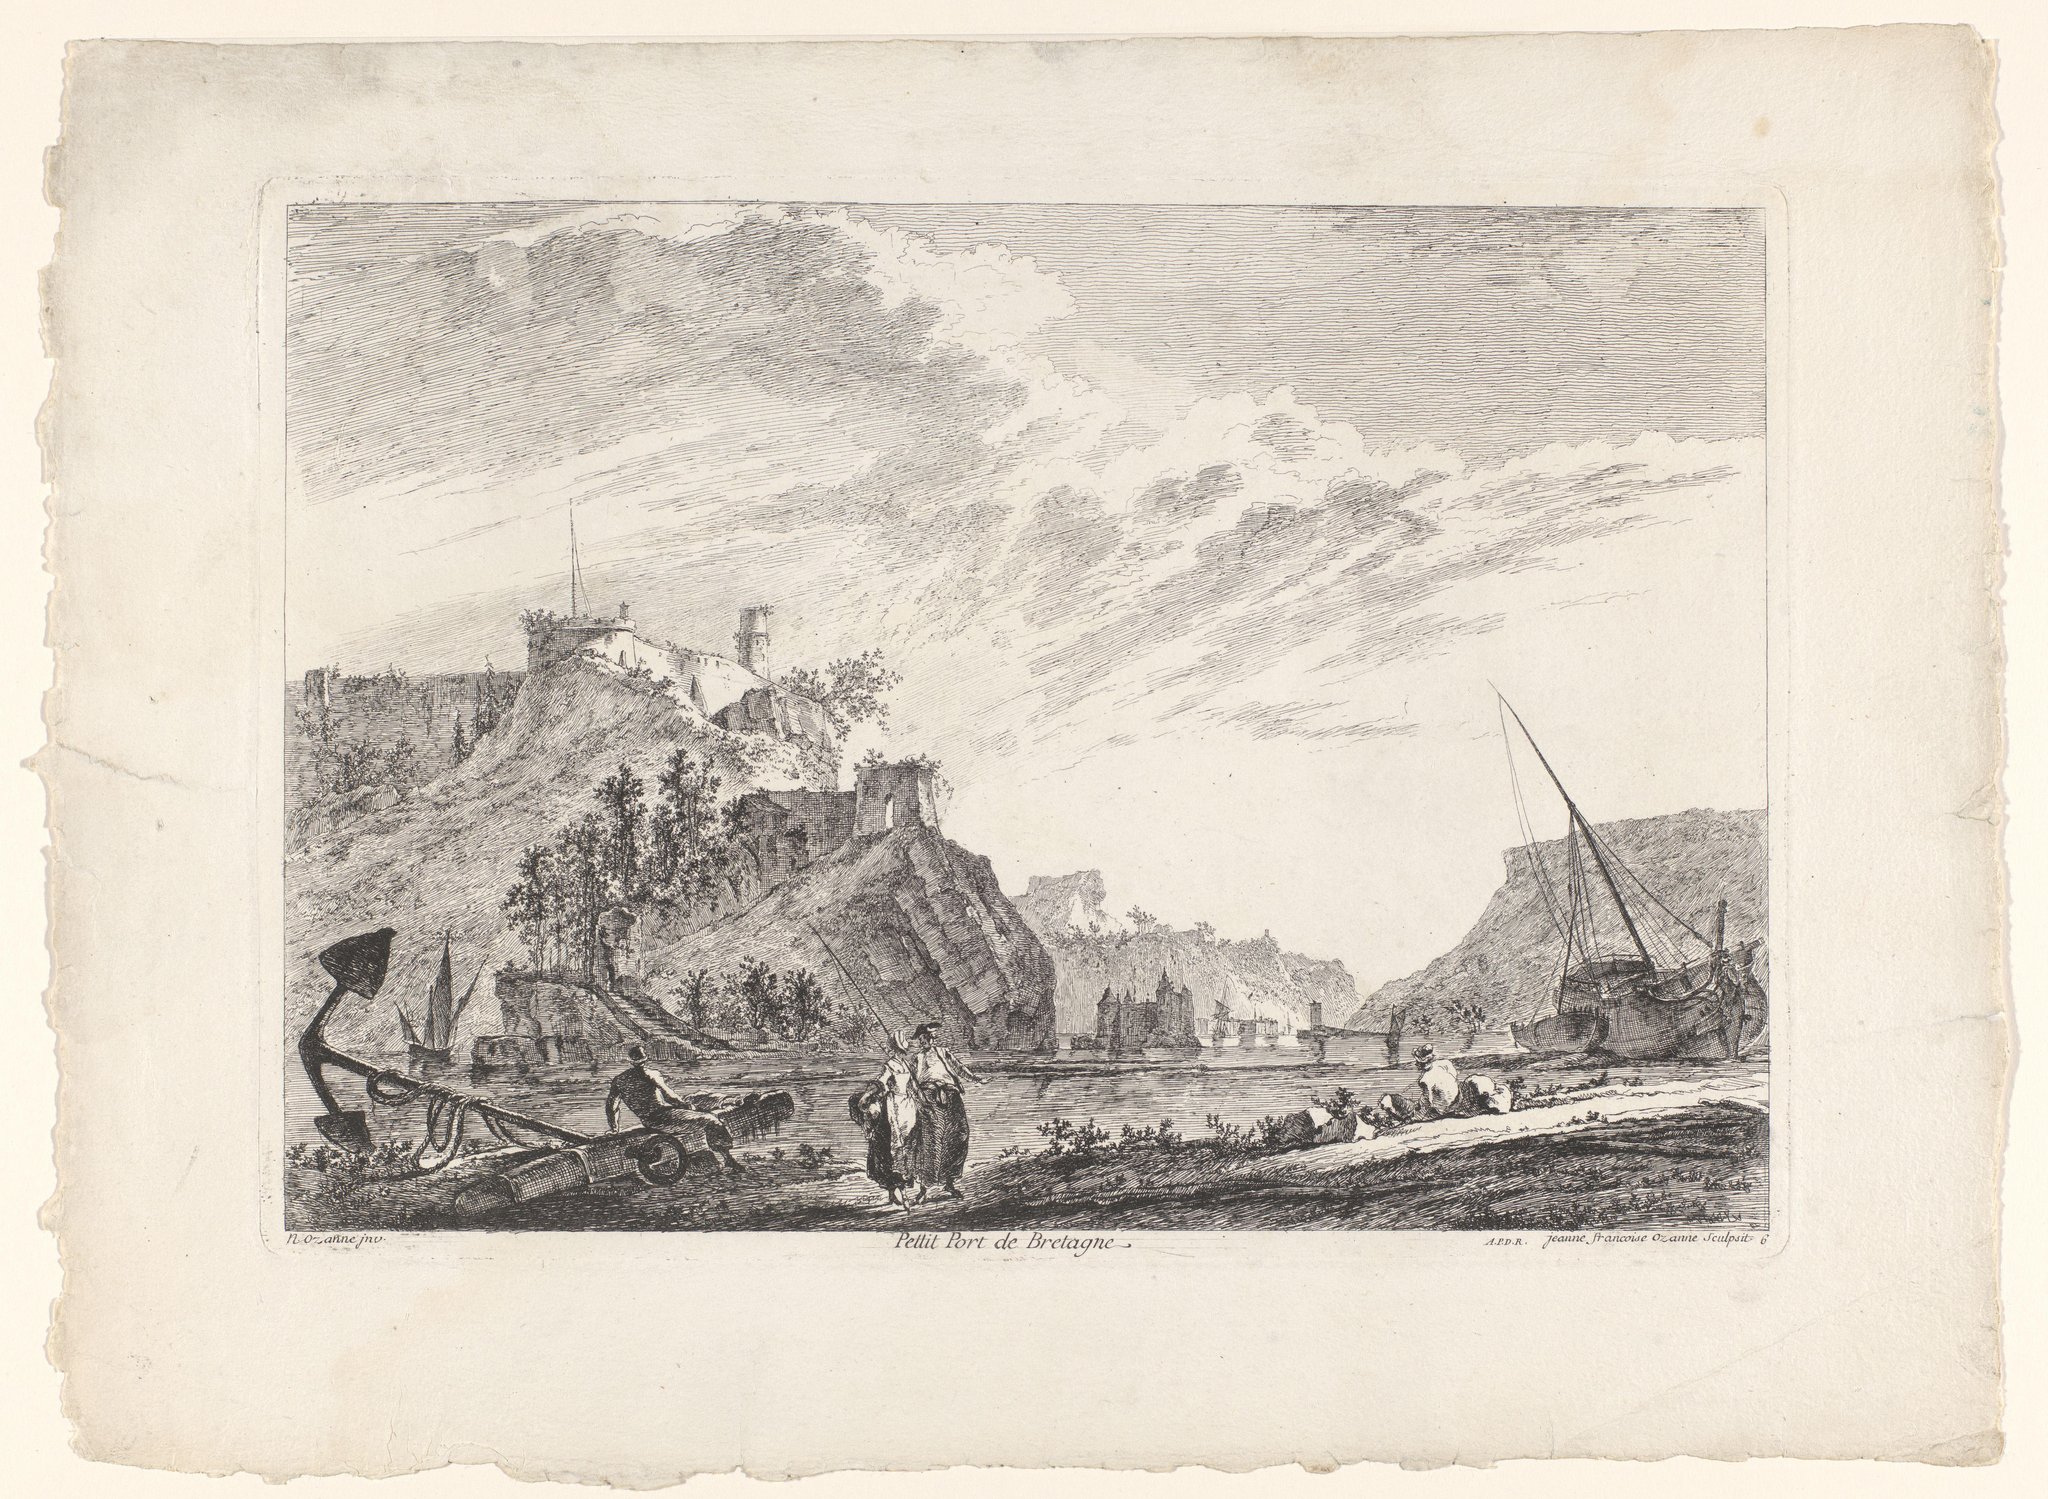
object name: print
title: Petit Port de Bretagne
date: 1760-1780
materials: paper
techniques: etching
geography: france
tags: harbour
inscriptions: collector's mark: Lugt 2228, collector's mark: Lugt 2760